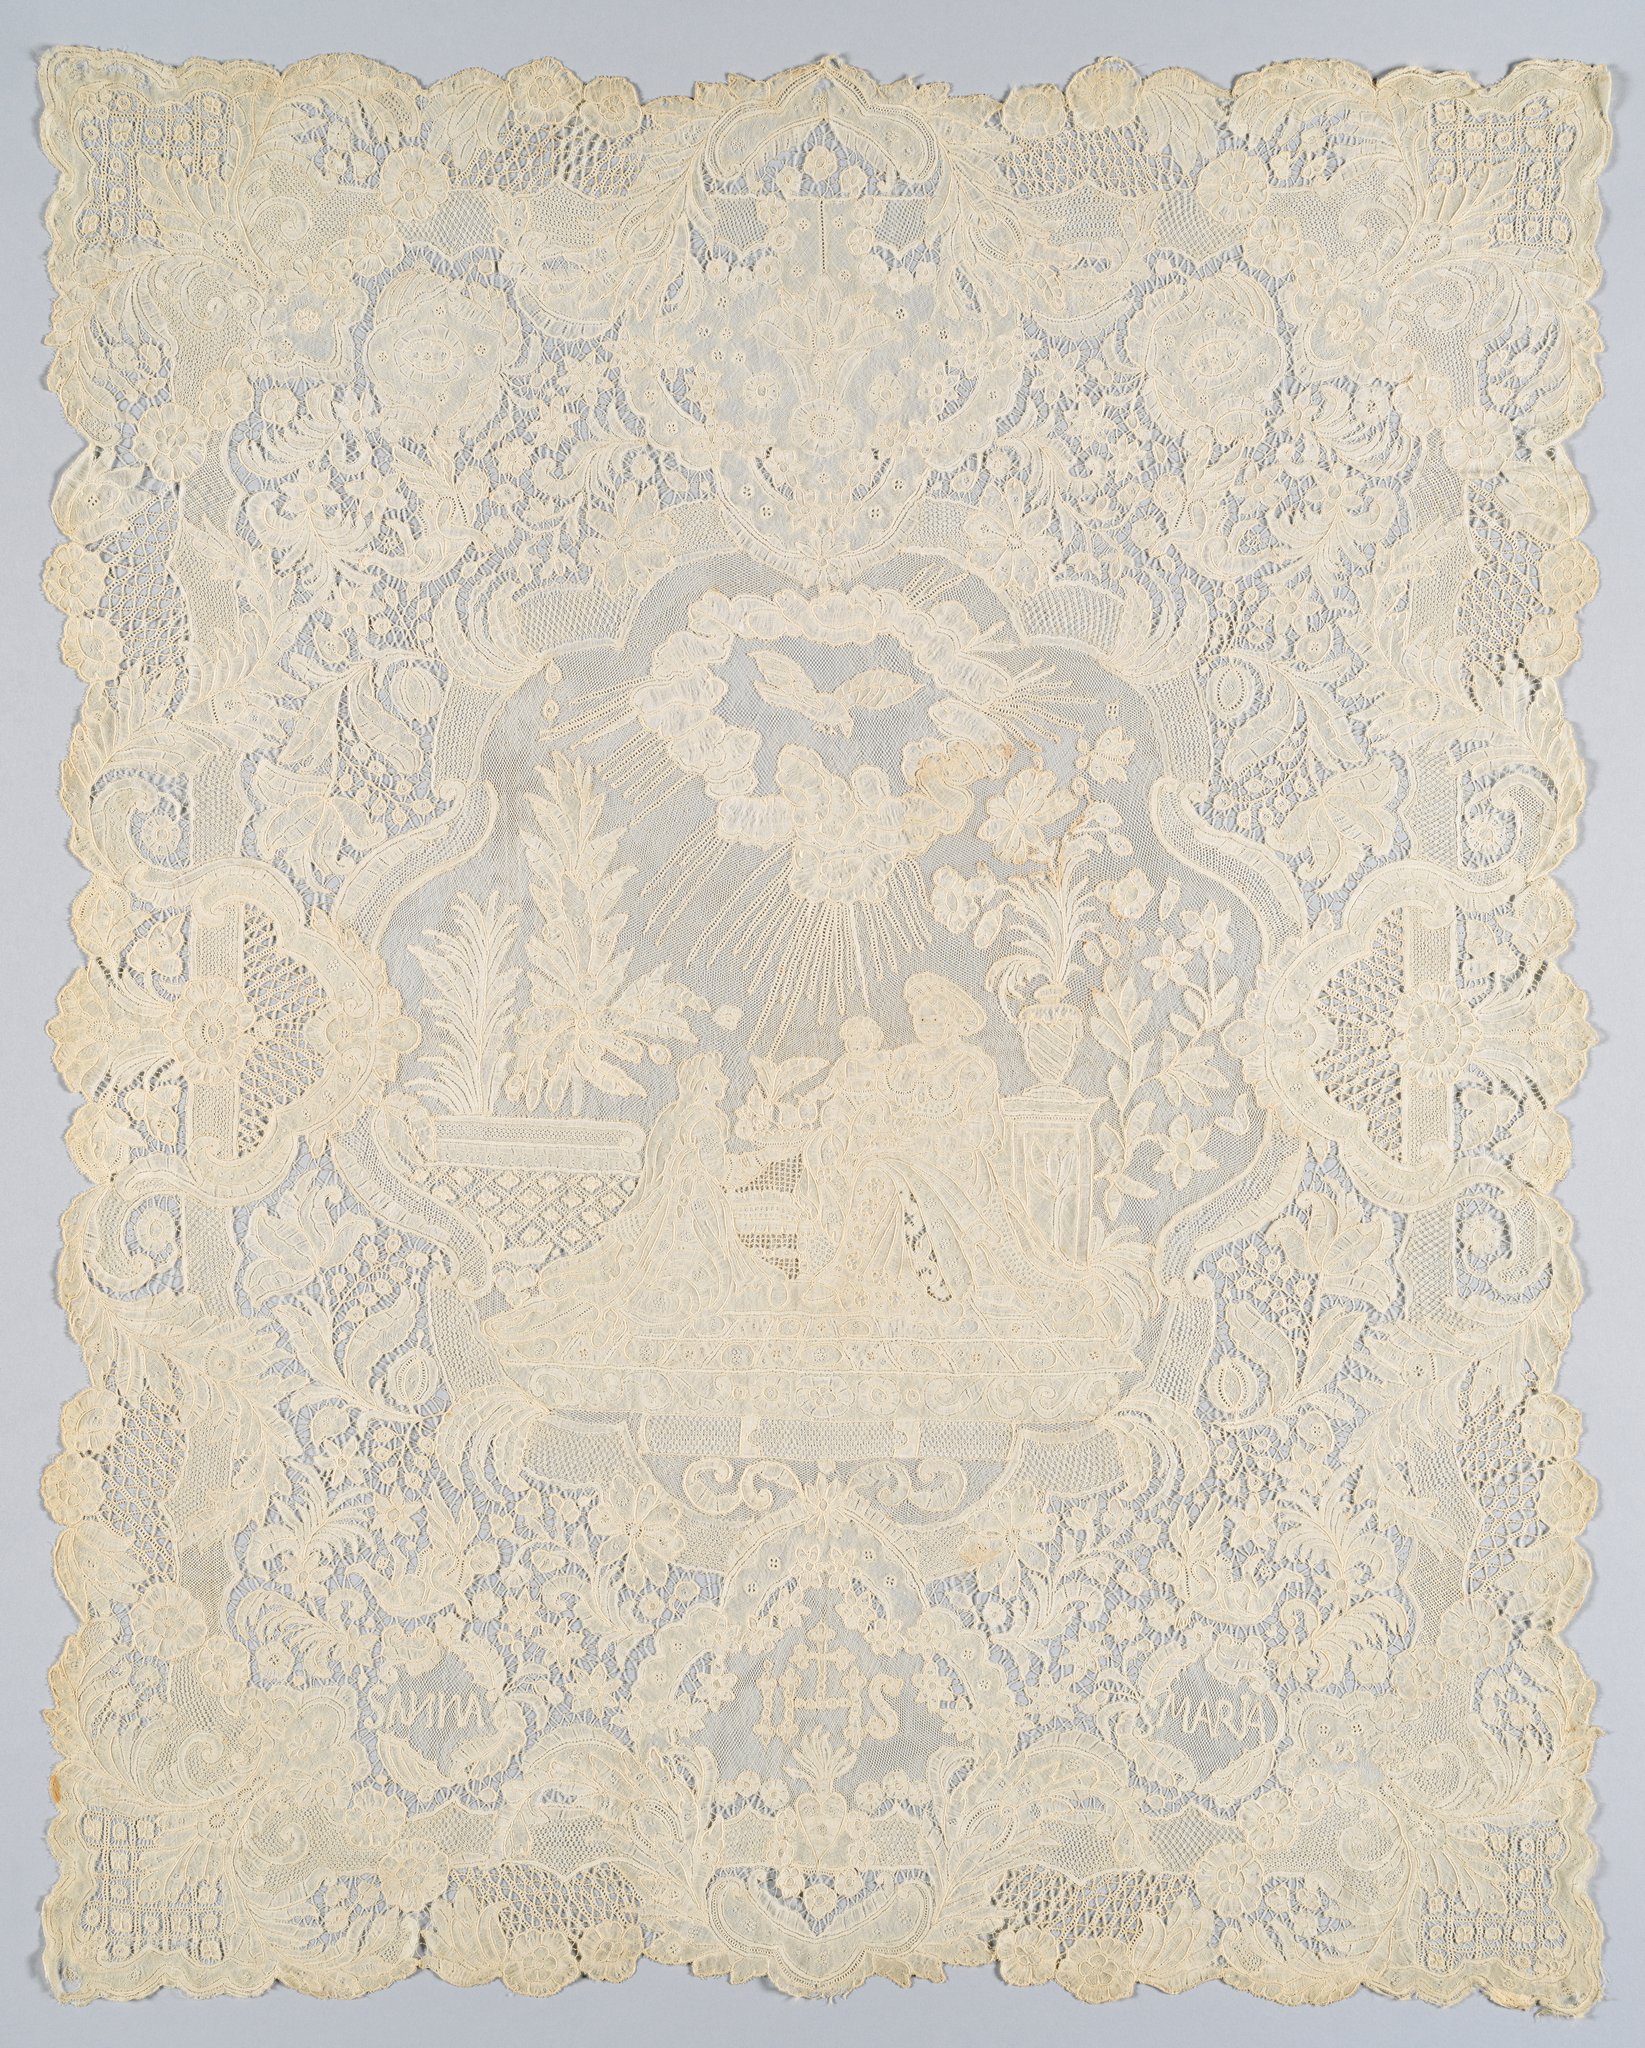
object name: veil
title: Benediction veil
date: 1745-1760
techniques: lace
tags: madonna and child